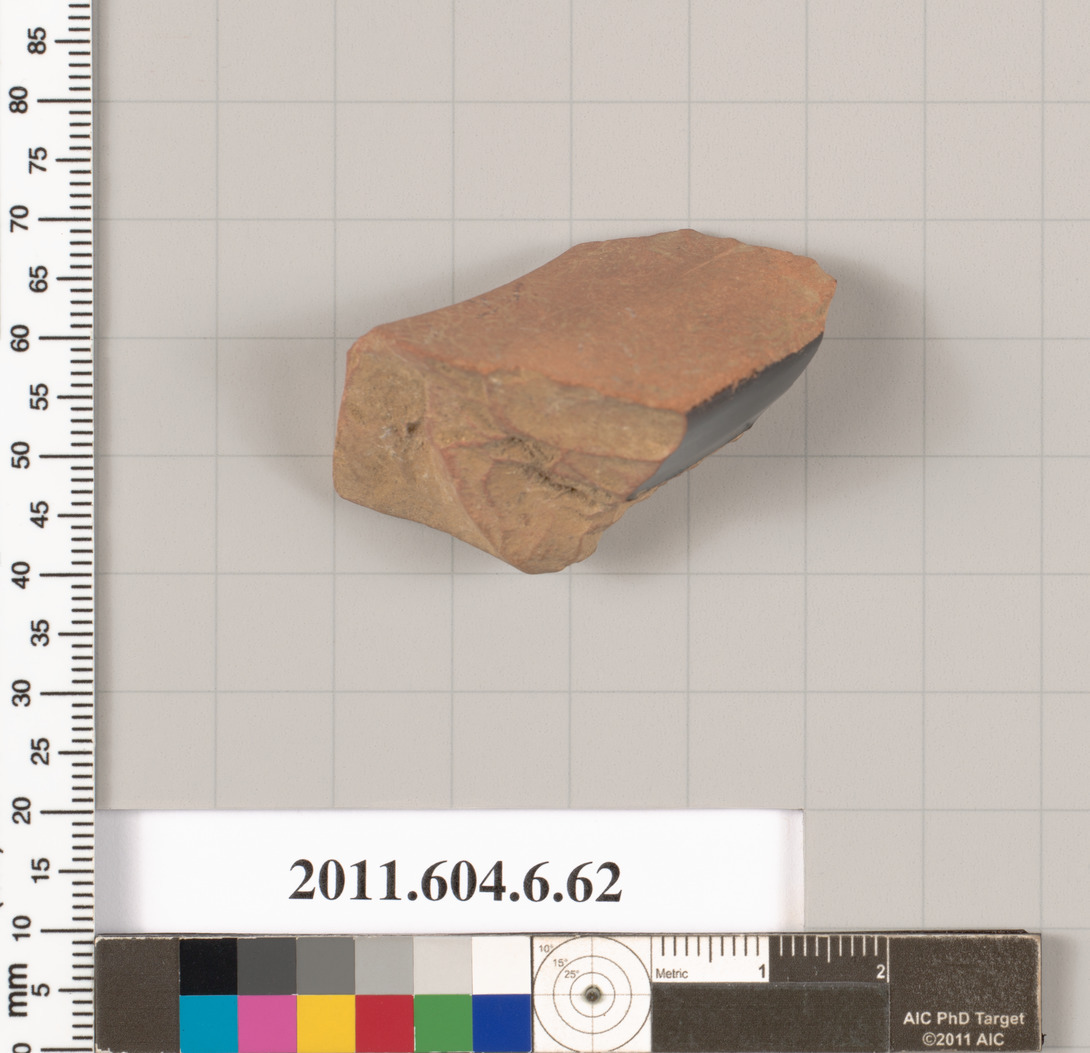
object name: undetermined shape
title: Terracotta fragment of an undetermined shape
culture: greek, attic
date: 600-401 BCE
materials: terracotta